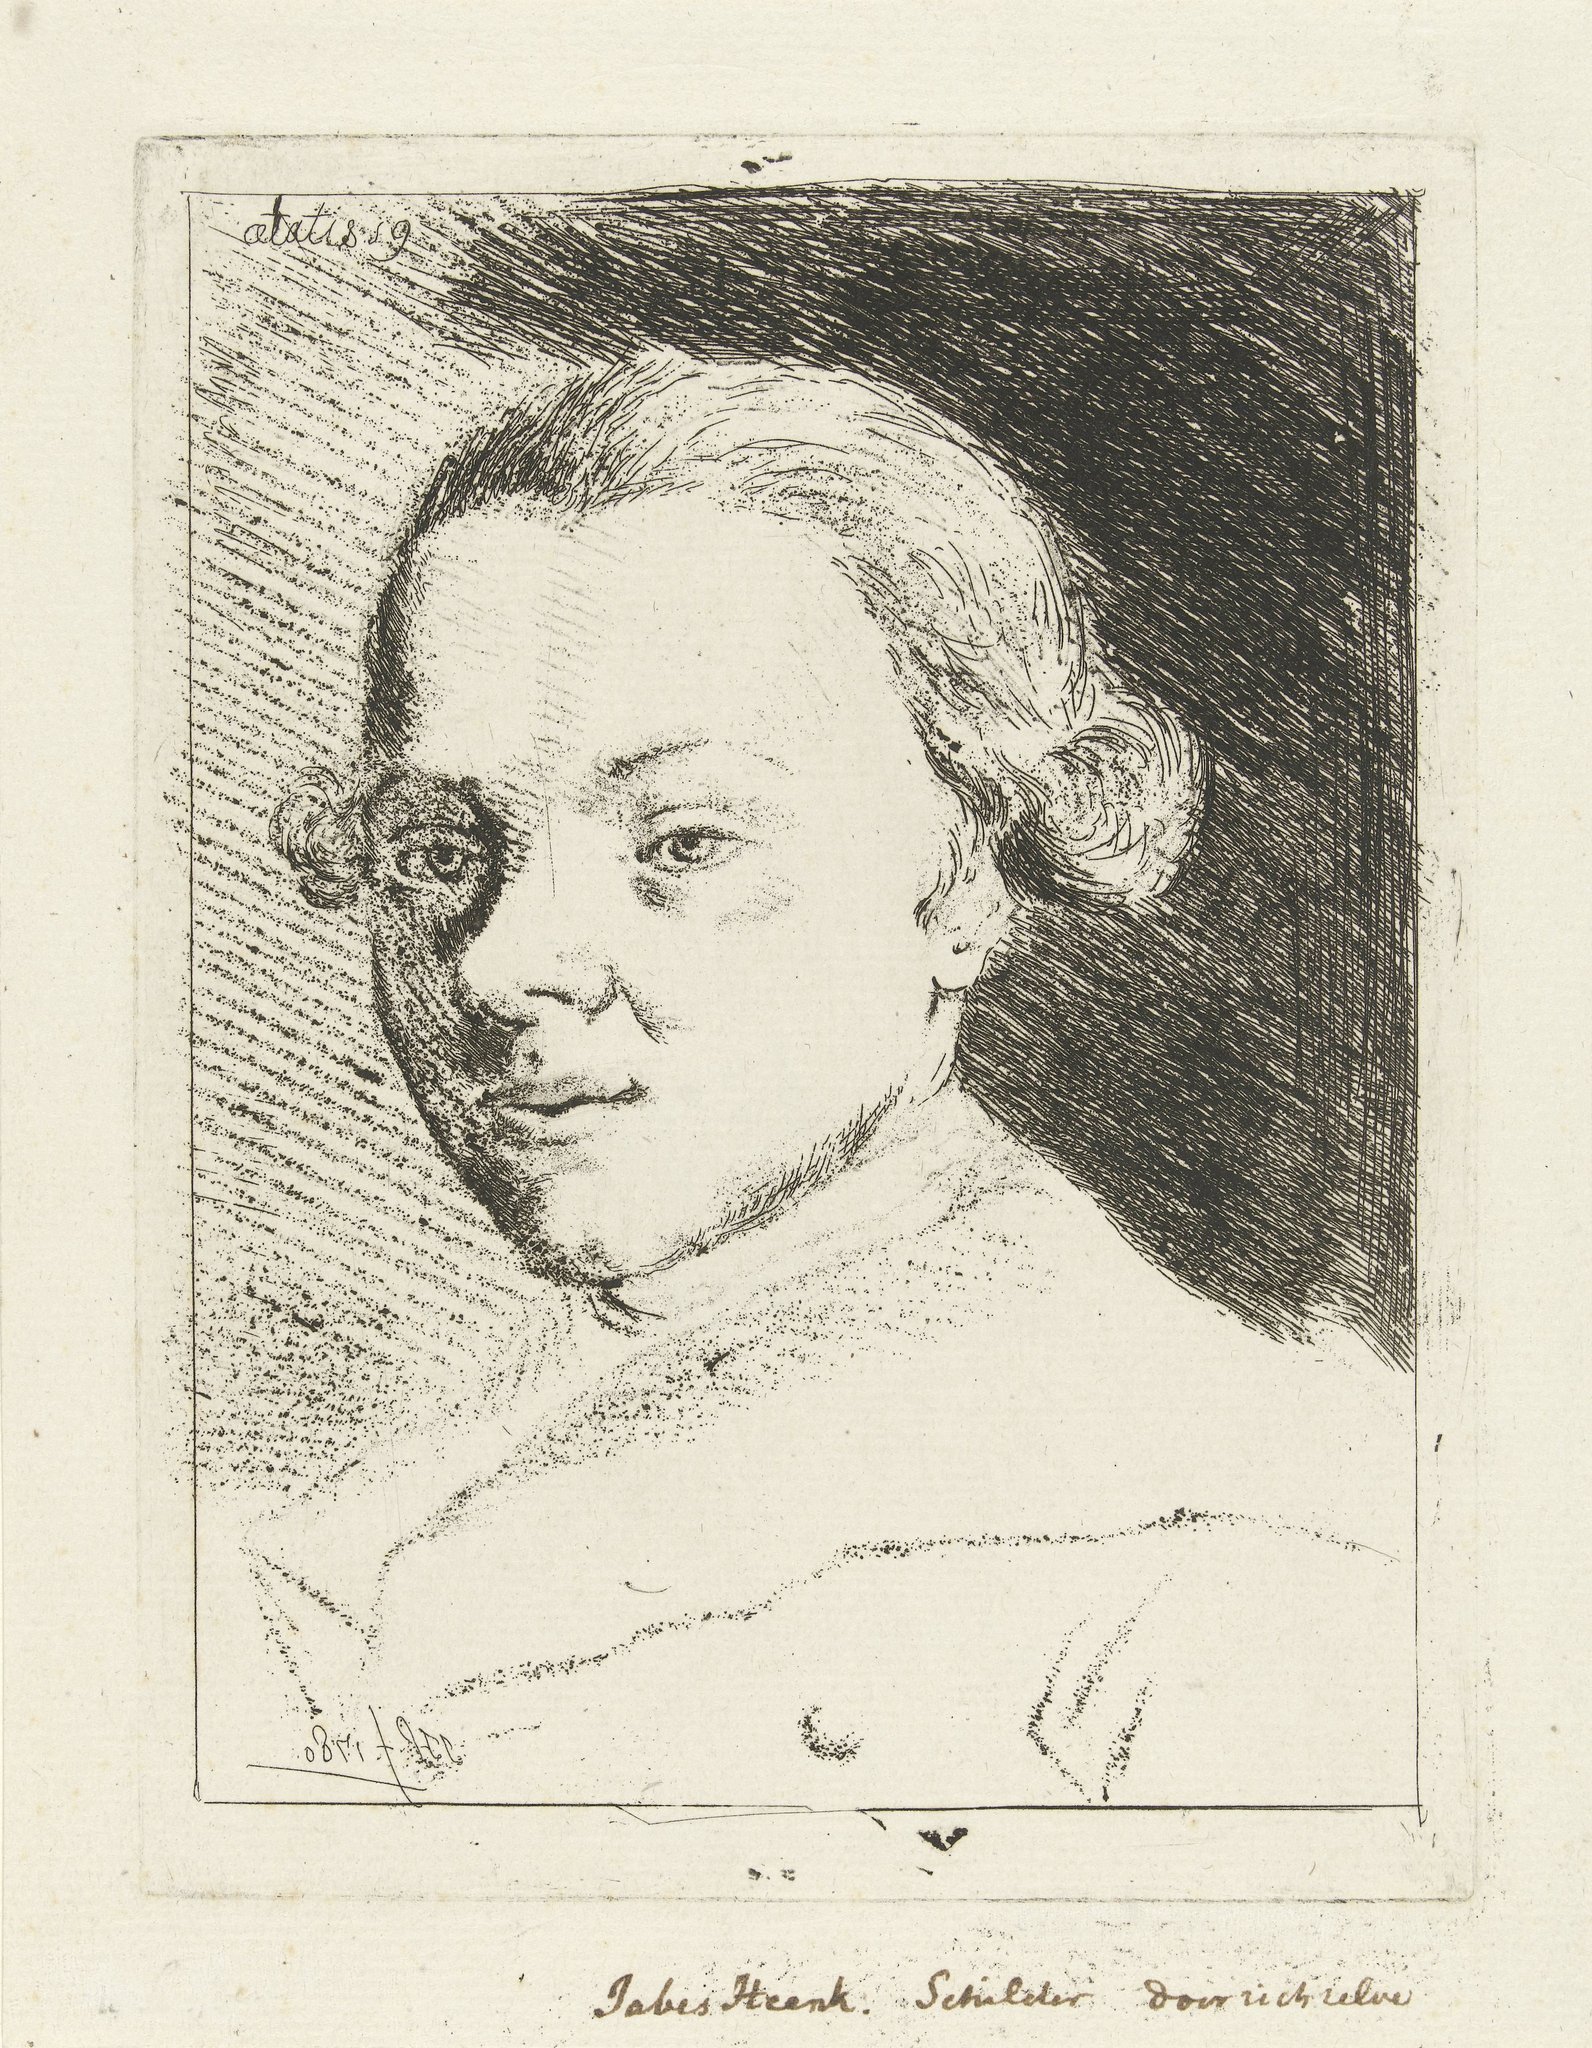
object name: print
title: Zelfportret van Jabes Heenck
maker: jabes heenck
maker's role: draughtsman, print maker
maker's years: 1752-1782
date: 1780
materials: paper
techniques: etching, soft ground etching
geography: northern netherlands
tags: the hague, leiden, print maker, draughtsman, jabes heenck, youth, adolescent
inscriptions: collector's mark: Lugt 2760, inscription, collector's mark: Lugt 2228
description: Buste naar links van de schilder Jabes Heenck. In de linkerbovenhoek in spiegelschrift: aetatits 19.